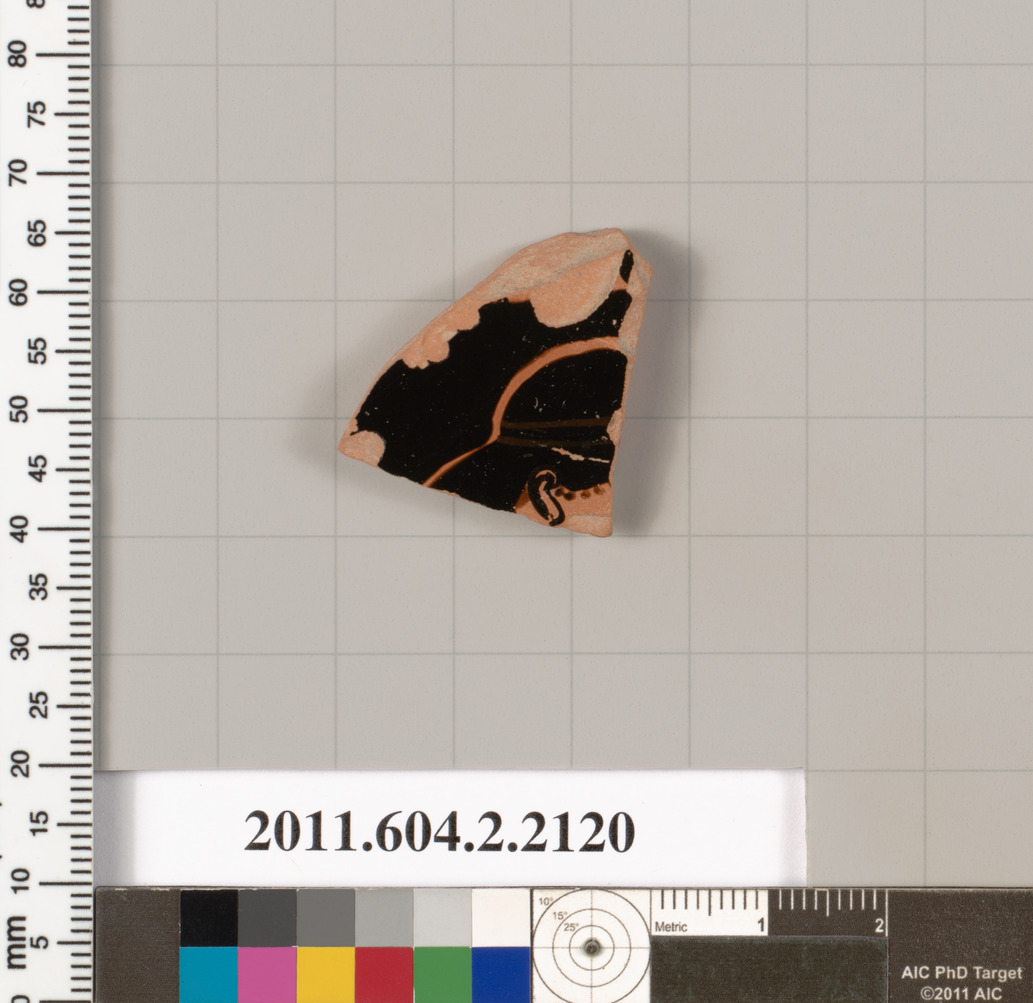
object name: pot fragment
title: Terracotta fragment of a pot; unglazed on the inside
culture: greek, attic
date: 480-470 BCE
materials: terracotta